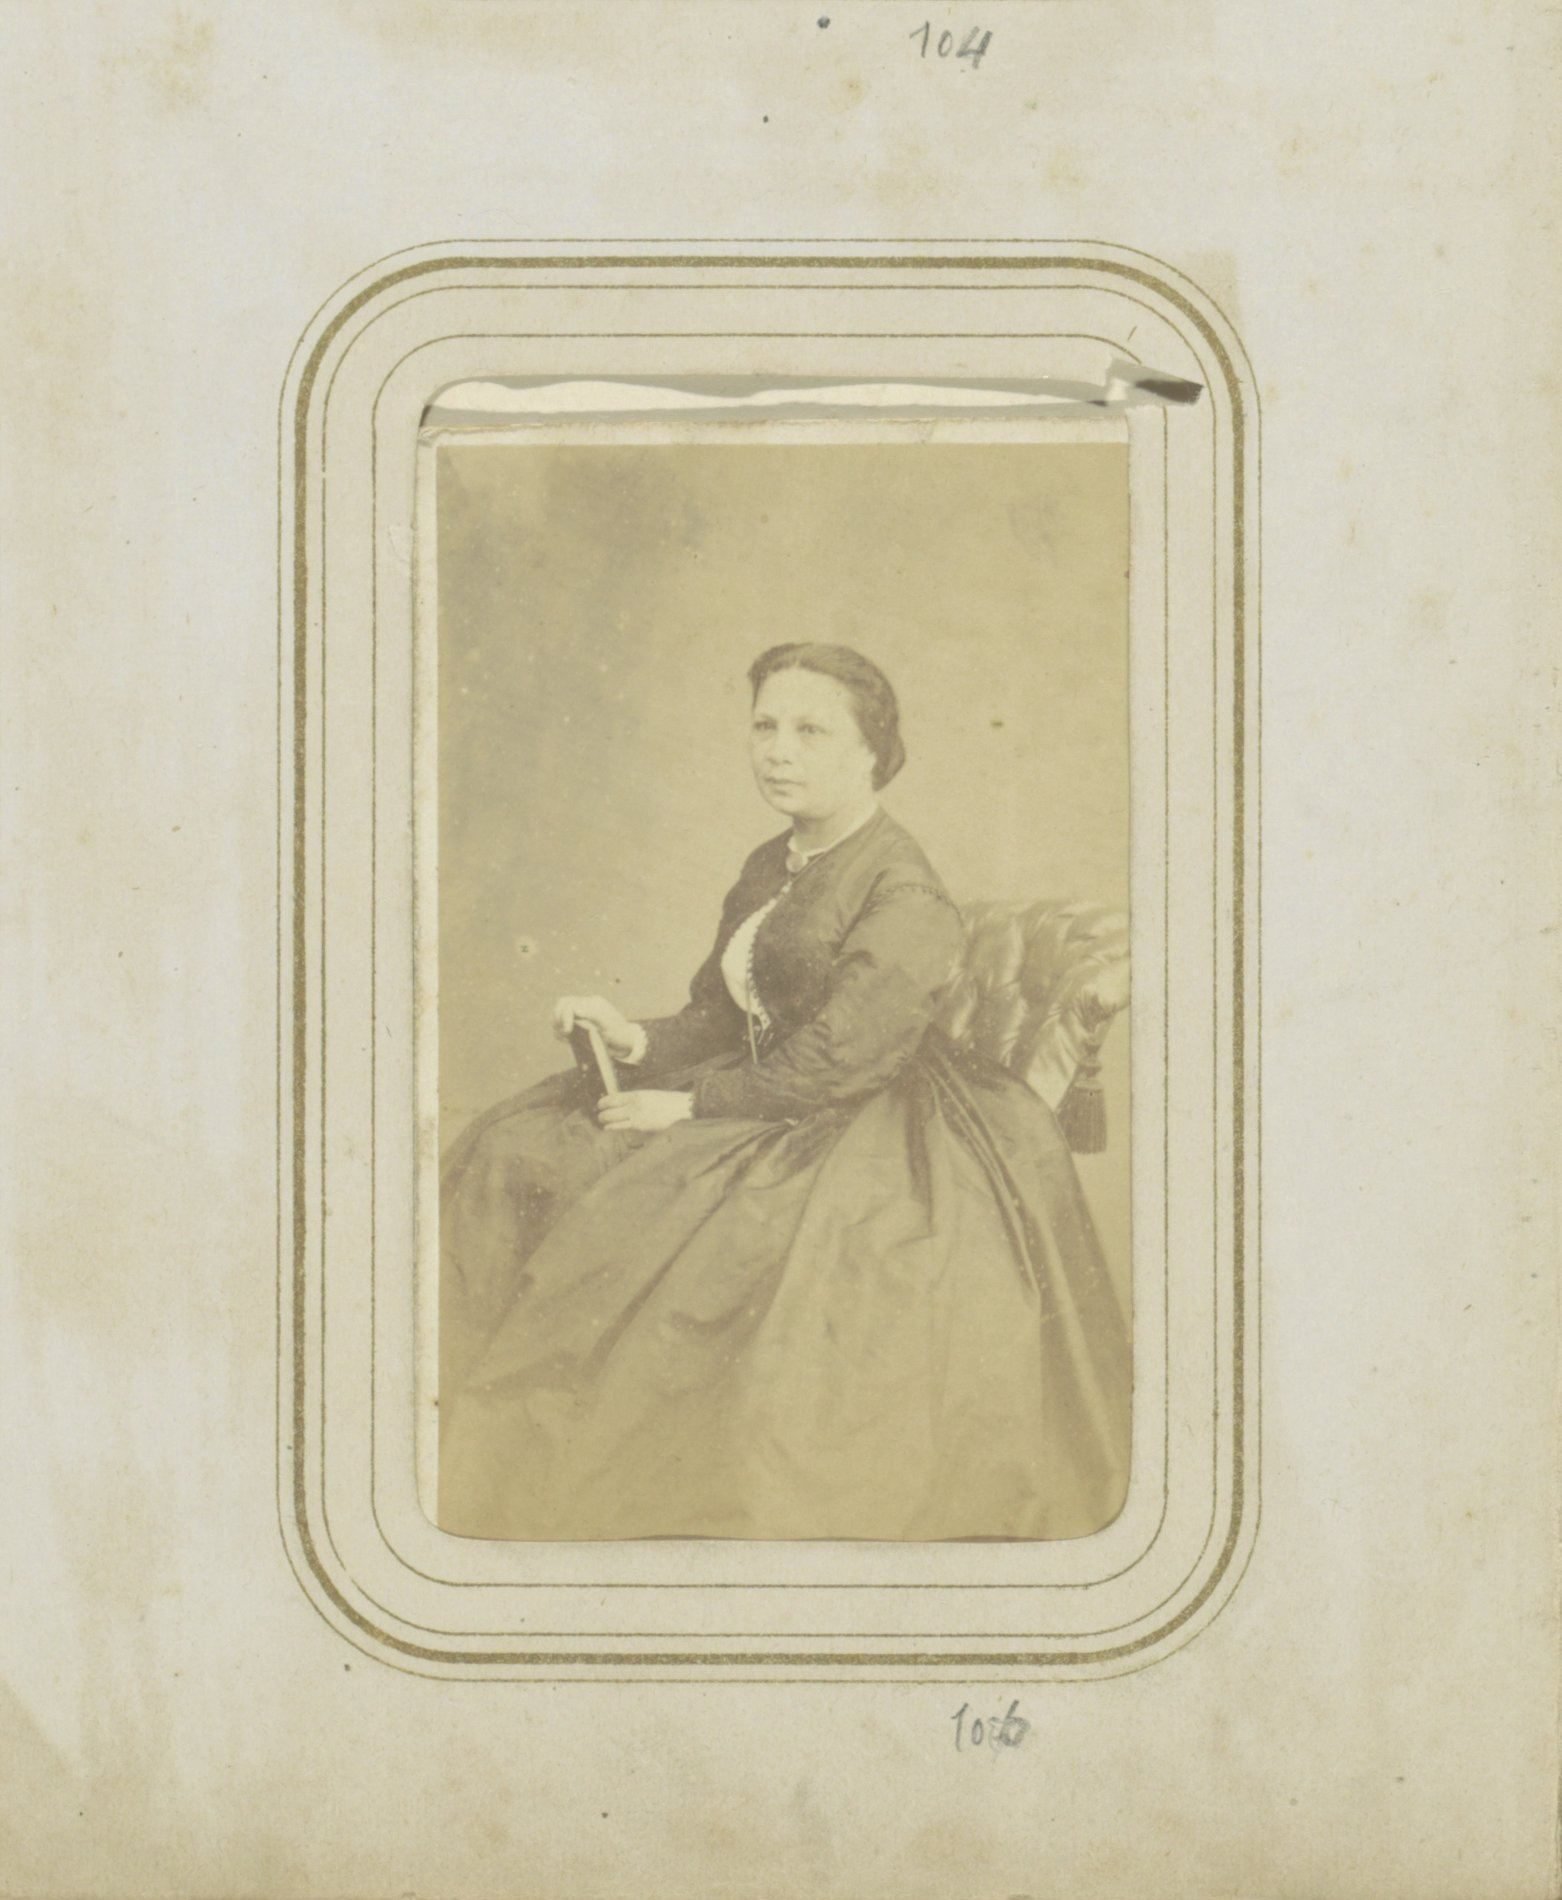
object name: carte de visite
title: Portret van een vrouw in een wijde jurk met een boek in de hand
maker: robert severin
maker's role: fotograaf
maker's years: 1839-1888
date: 1860-1875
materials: cardboard, photographic support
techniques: albumen print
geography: the hague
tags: studio requisites ~ photographer, historical persons, styles of hairdress - aa - ~ women, clothing for the upper part of the body, skirt, family, relationship, descent, book, dress, gown, the hague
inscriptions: address: ‘Noordeinde 109 La Haye’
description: Onderdeel van Familiealbum van H.W.F. Ligtenberg en L.M. Swart met 149 foto's en cartes-de-visite.